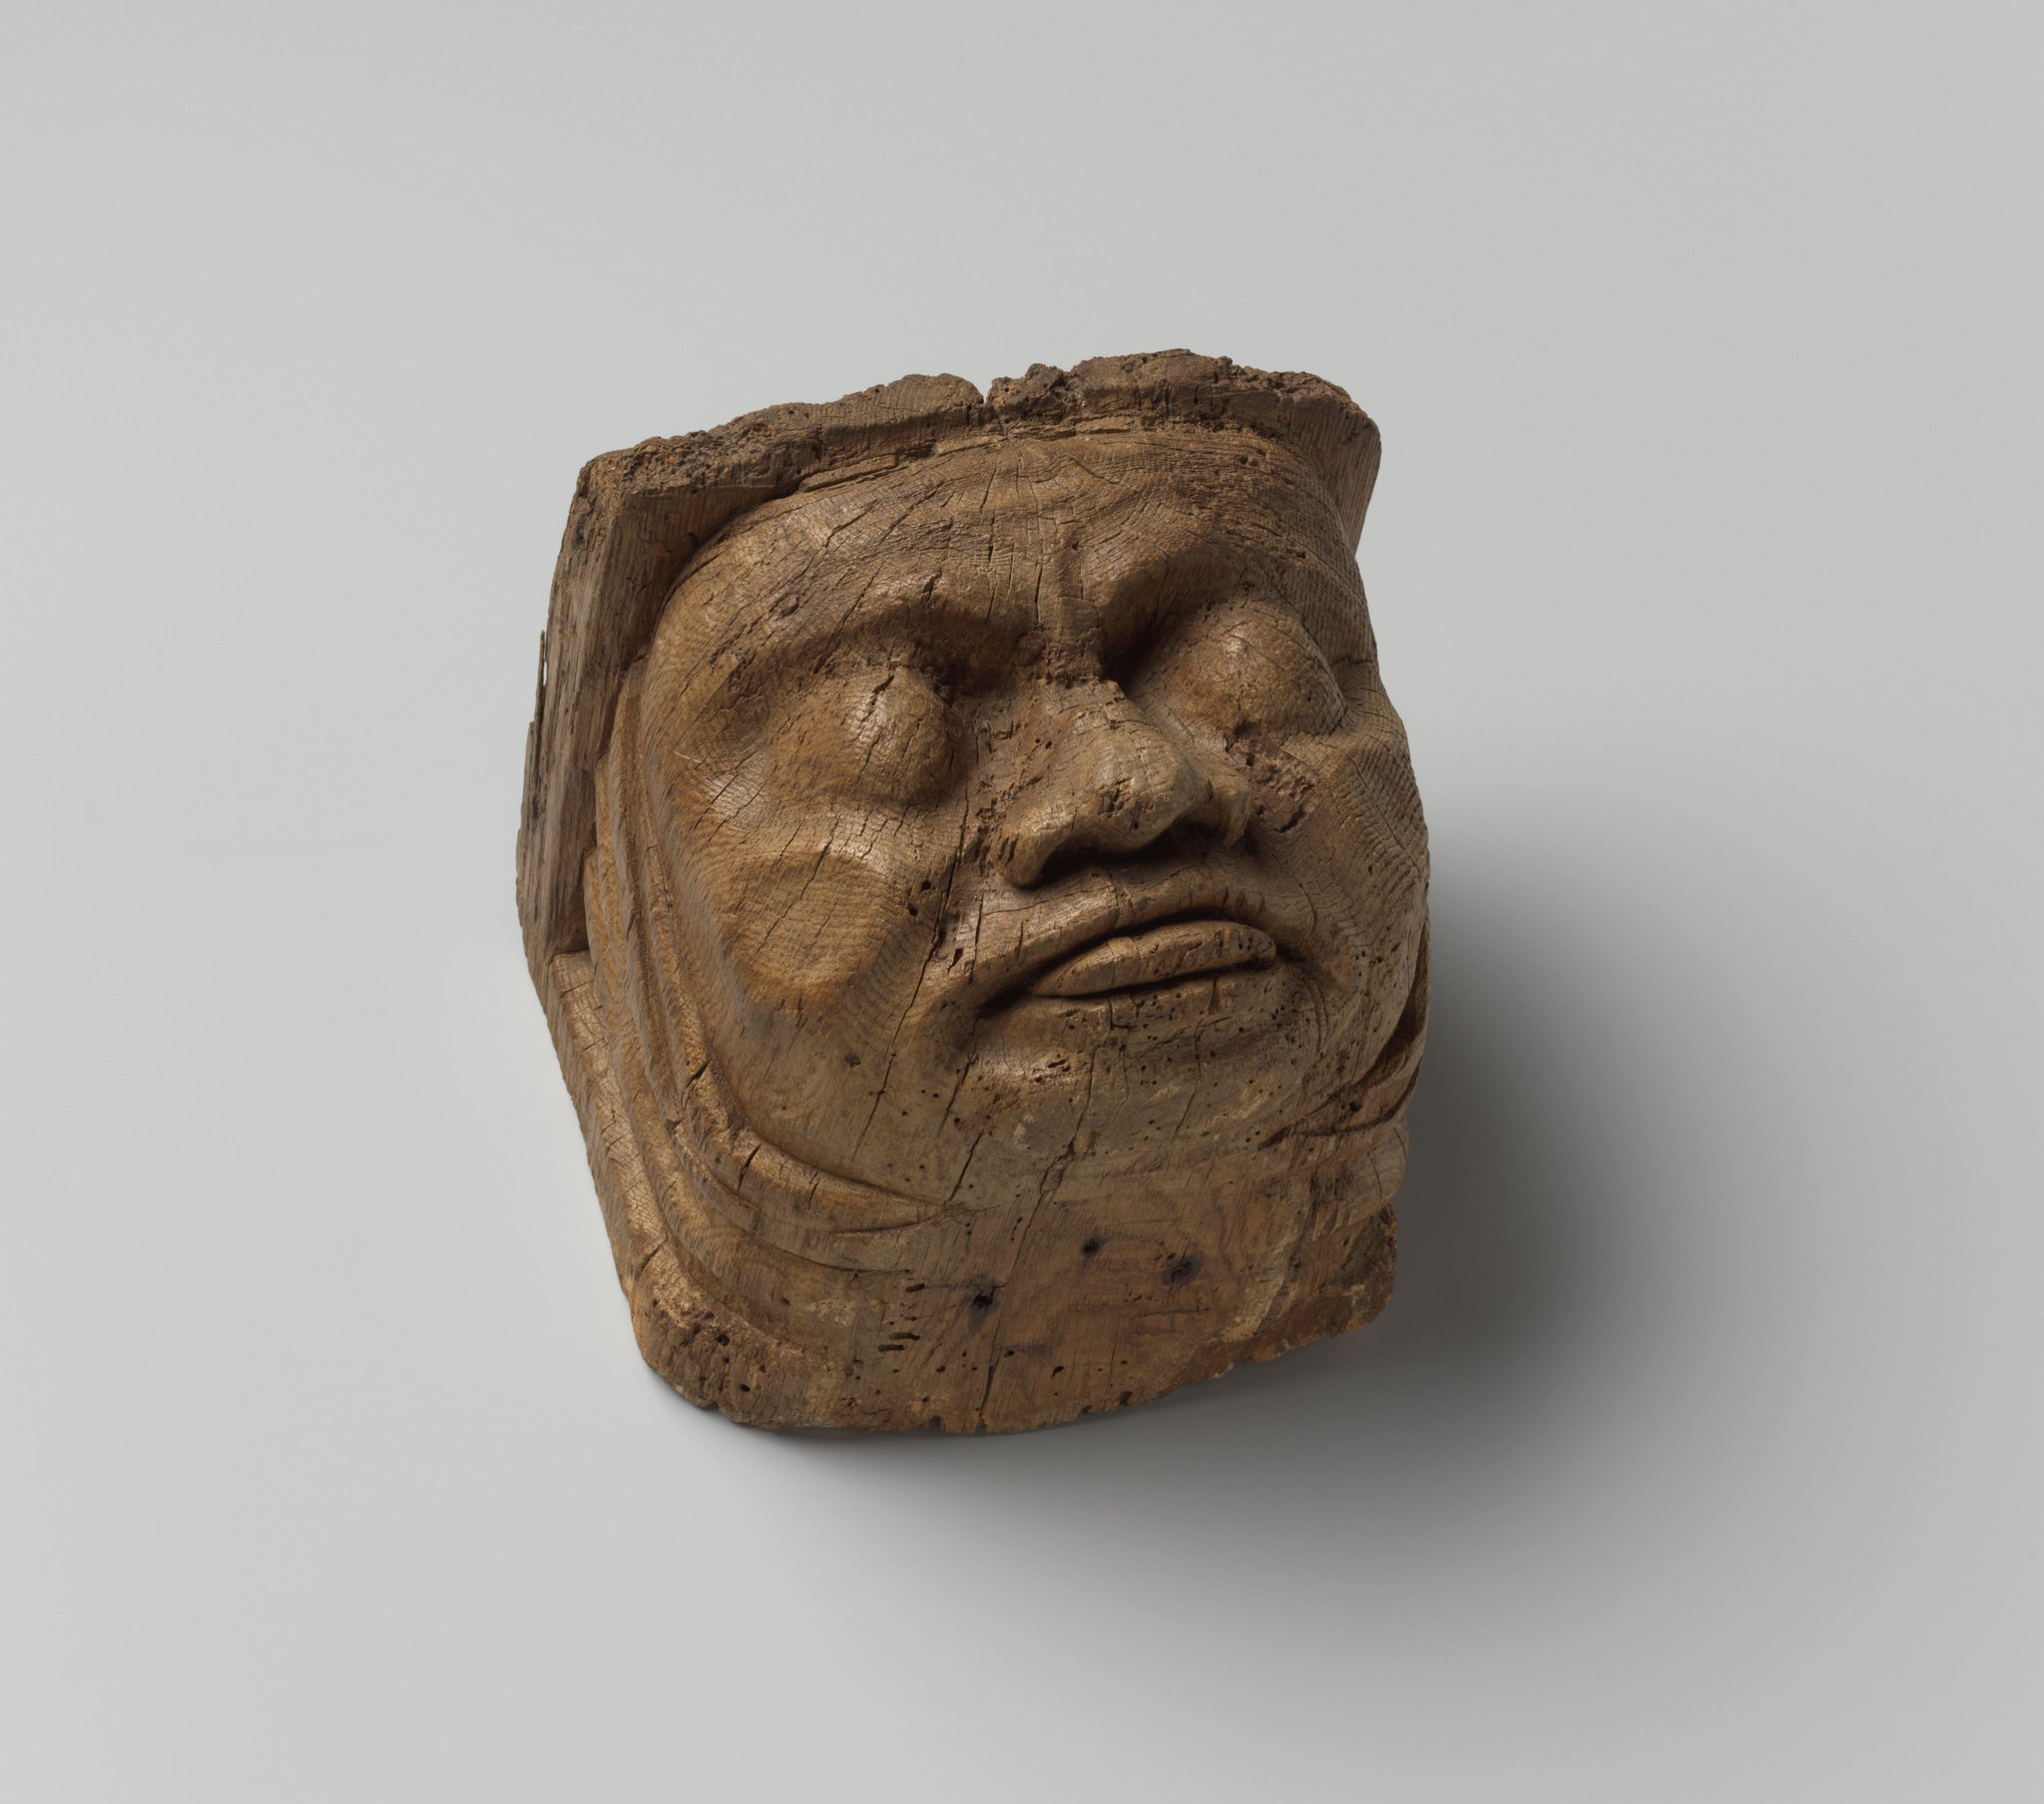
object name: architectural element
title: Bouwfragment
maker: Anonymous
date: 1400-1499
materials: wood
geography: northern netherlands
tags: rumpt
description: Kraagstuk van eikenhout of drager van een der muurstijlen van de kap over het koor van de kerk te Rumpt, voorstellende een mannekop. Zie tevens: BK-NM-11079, 11081 en 11082.